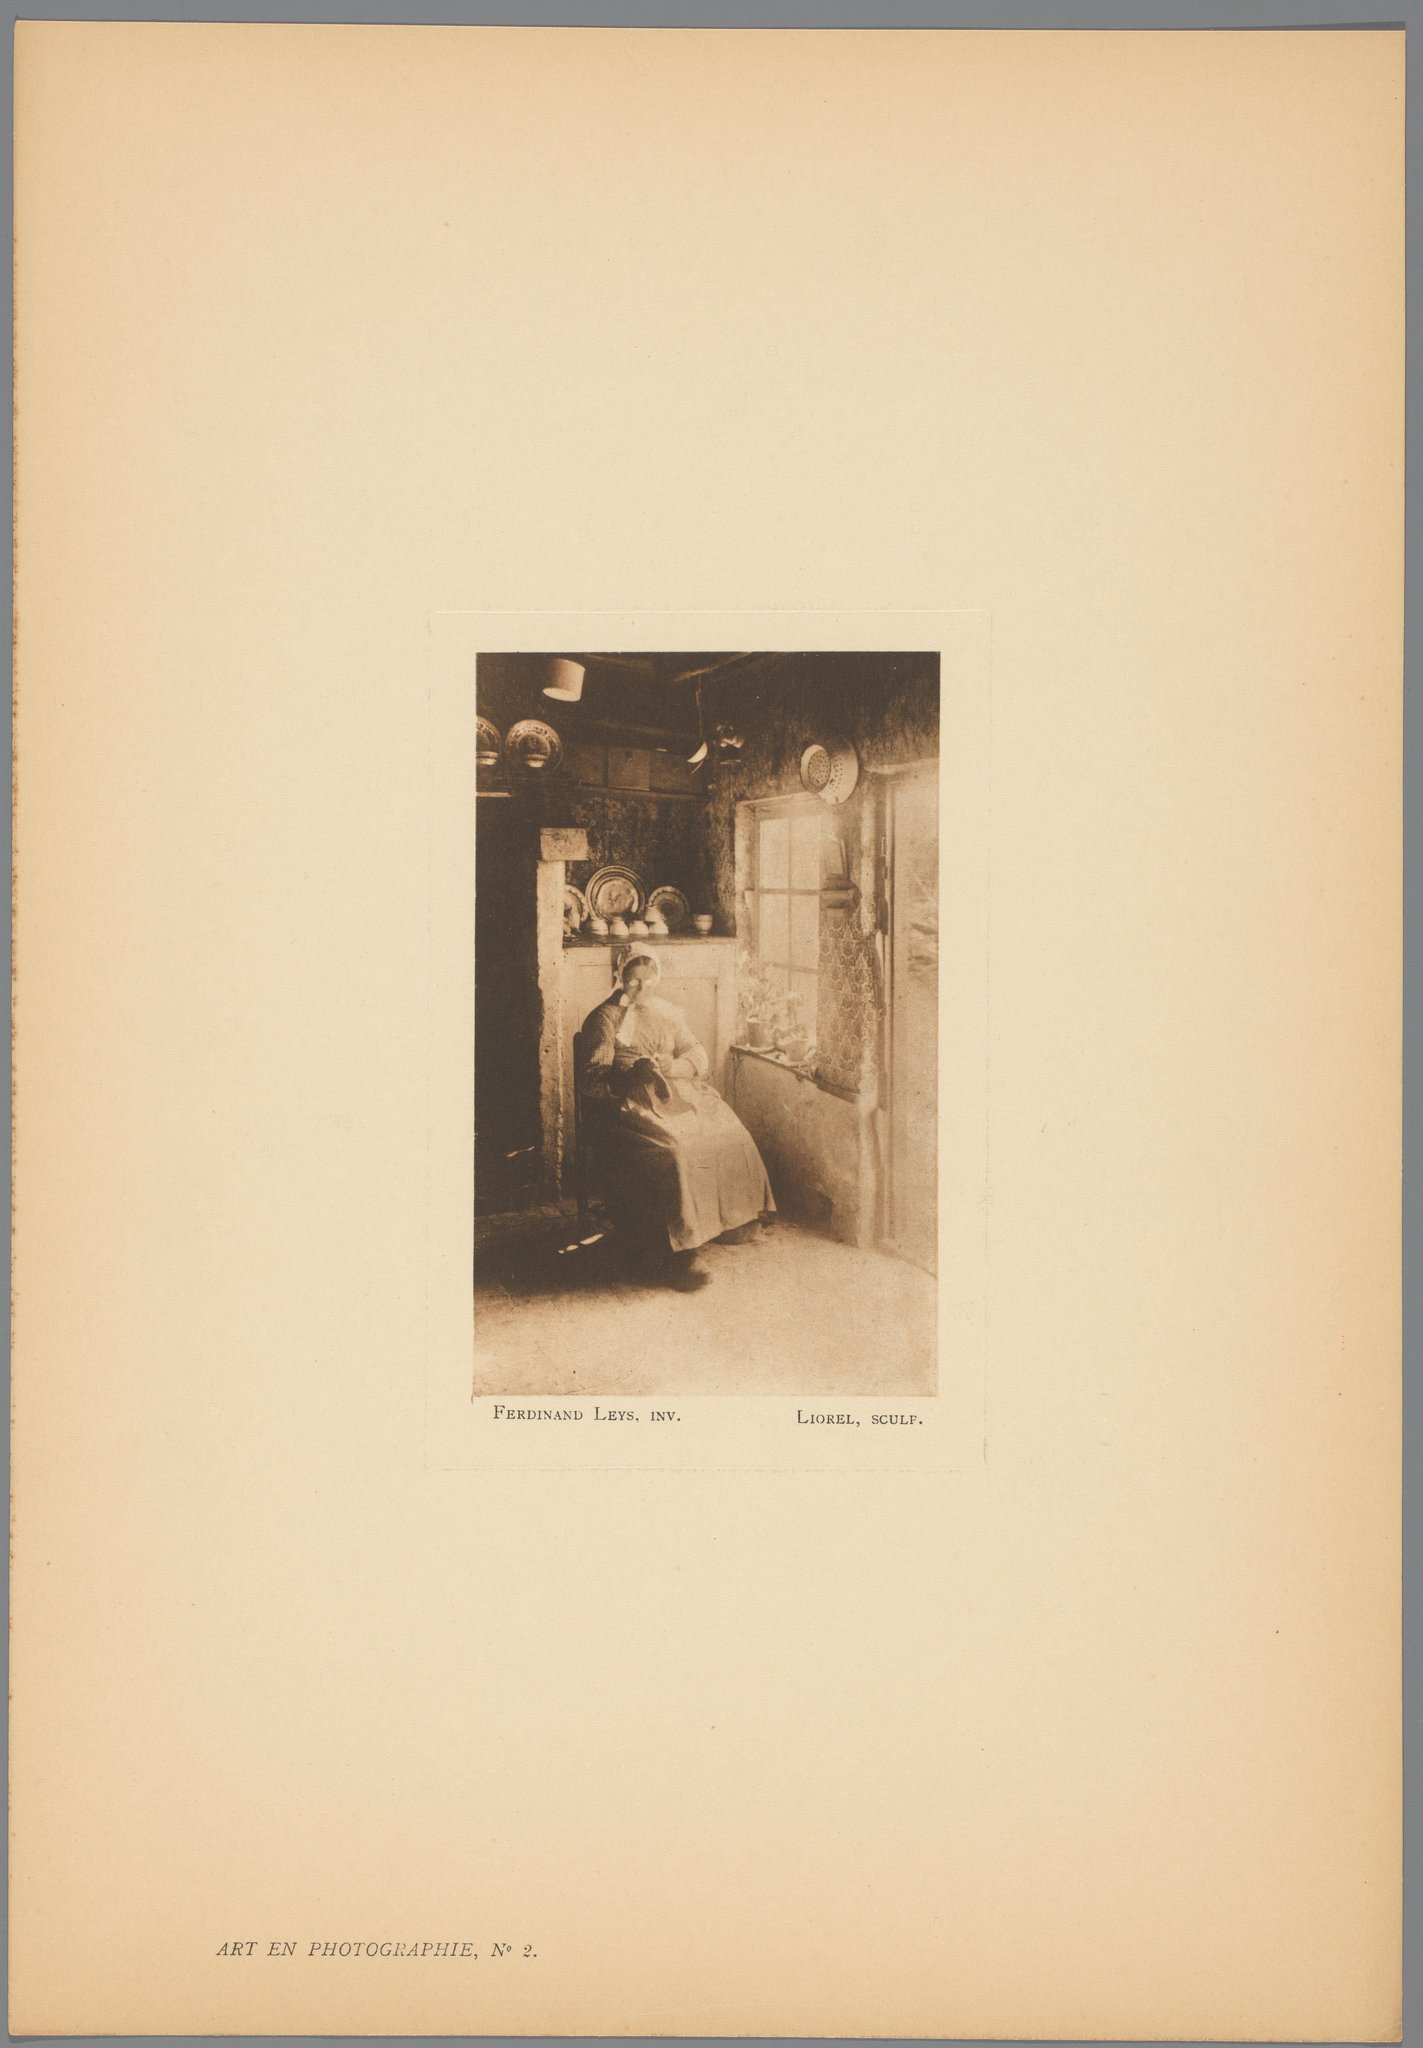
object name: photomechanical print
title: Vrouw op een stoel met naaiwerk in de hand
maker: ferdinand leys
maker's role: fotograaf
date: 1896-1901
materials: paper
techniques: photograph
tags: adult woman, home sewing; repair of clothes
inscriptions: inscription: ‘ART EN PHOTOGRAPHIE, No 2.’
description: Deze prent maakt deel uit van een omslag met 54 prenten op 52 bladen.